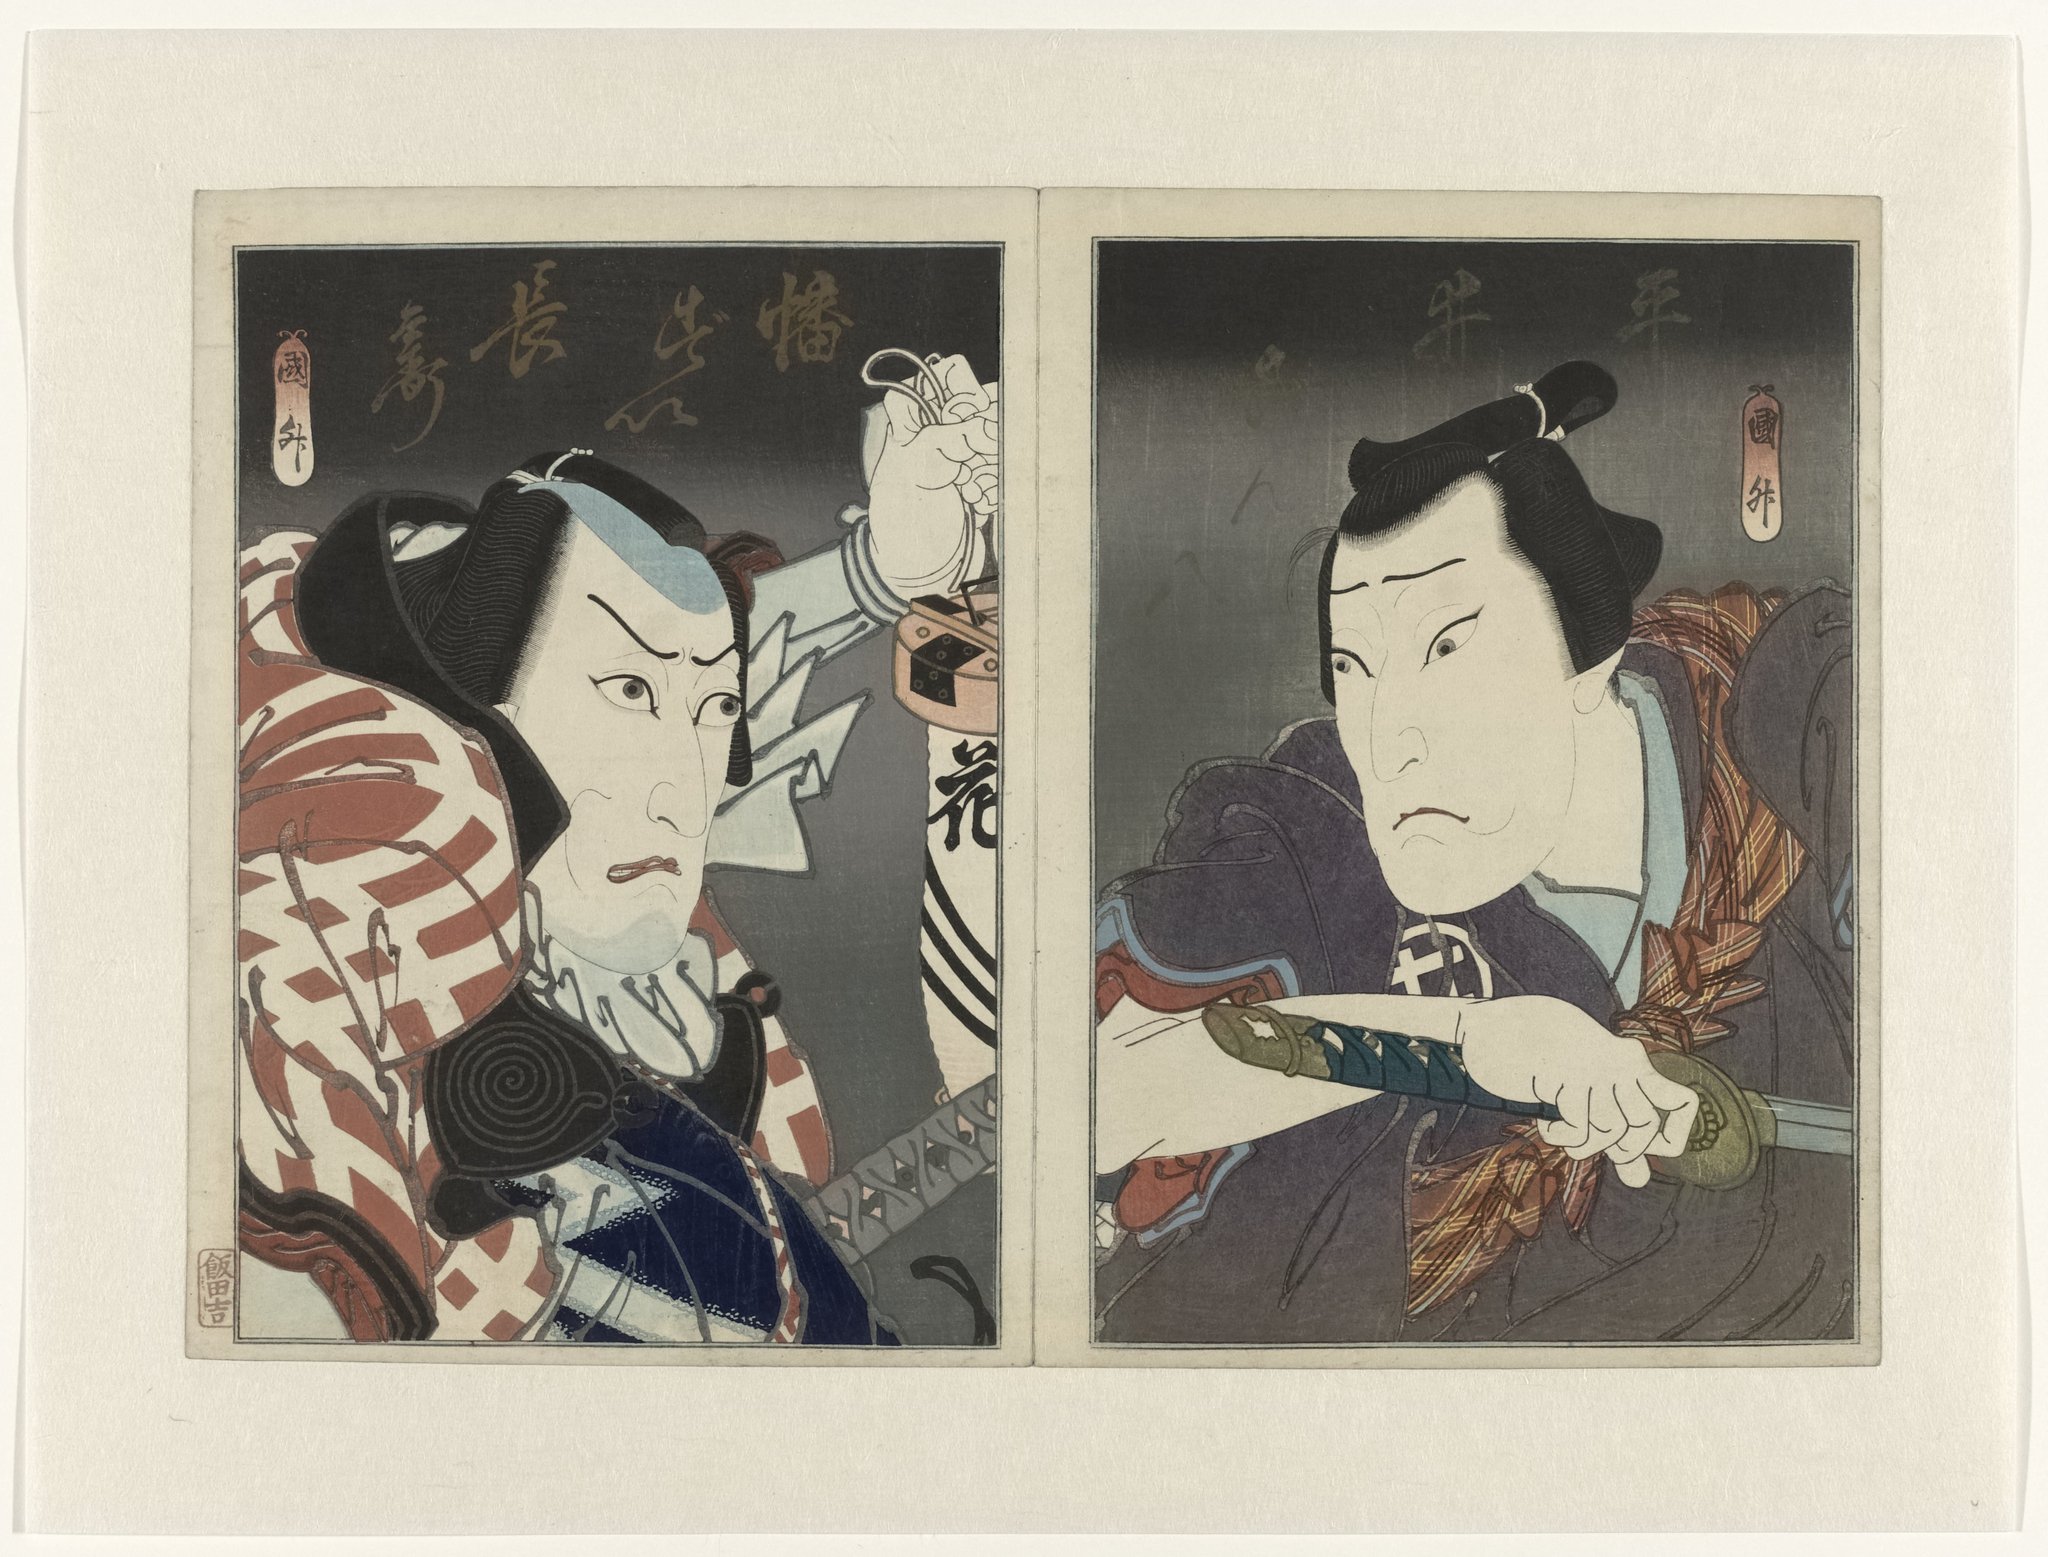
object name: print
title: Ichikawa Ebizô V als Banzui Chôbei (l.) en Ôkawa Hashizô I als Hirai Gonpachi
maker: utagawa kunimasu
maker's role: print maker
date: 1808-1848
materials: paper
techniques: woodcut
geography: osaka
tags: japan, portrait of actor, actress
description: Ichikawa Ebizô V als Banzui Chôbei (links) en Ôkawa Hashizô I als Hirai Gonpachi in het toneelstuk ‘Sangoku ichi tsui no kuromono’ (ook wel getiteld: Sangoku daiichi nochi no kusemono), Kado Theater, augustus 1848. Chûban diptiek.